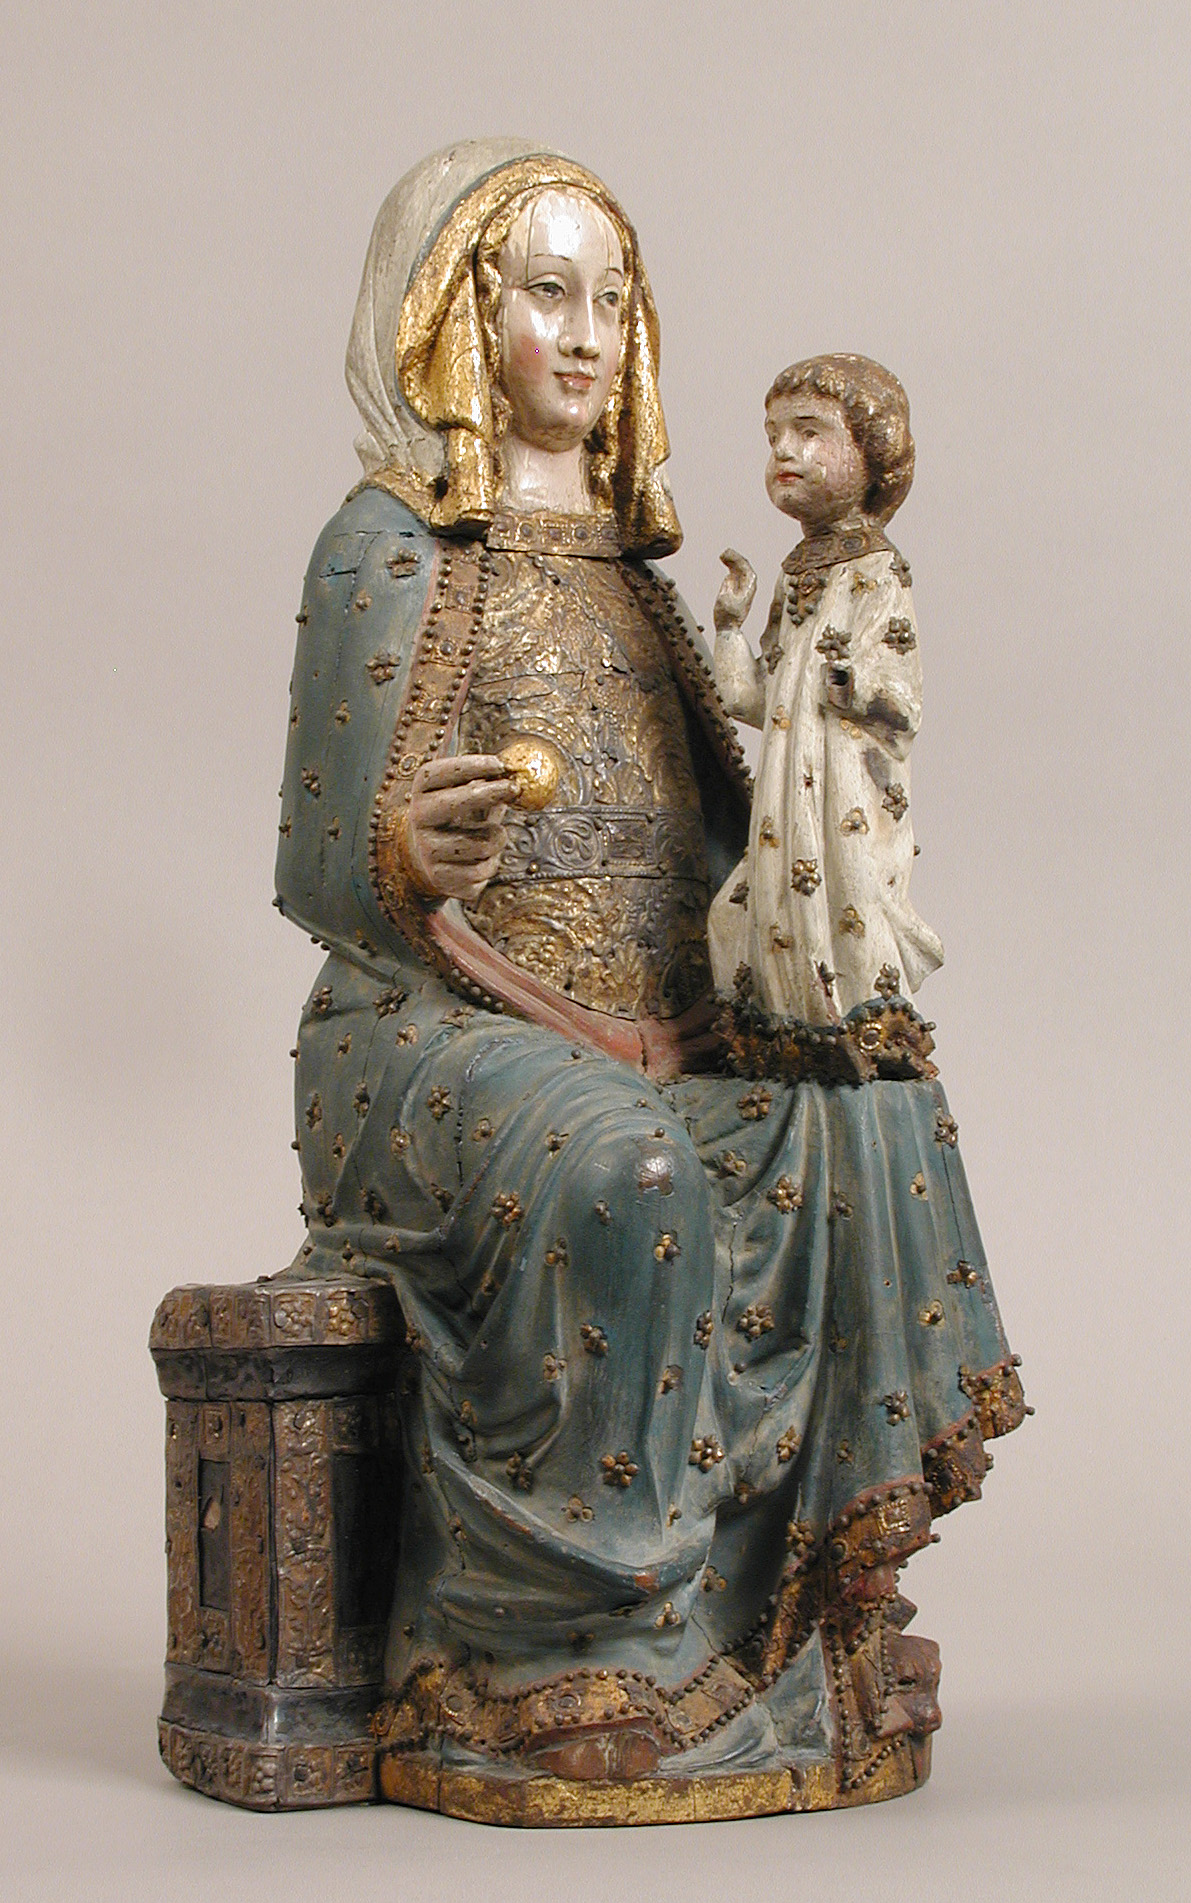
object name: statuette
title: Seated Virgin and Child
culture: spanish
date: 1467-1500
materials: brass, ivory, paint, wood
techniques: gilding